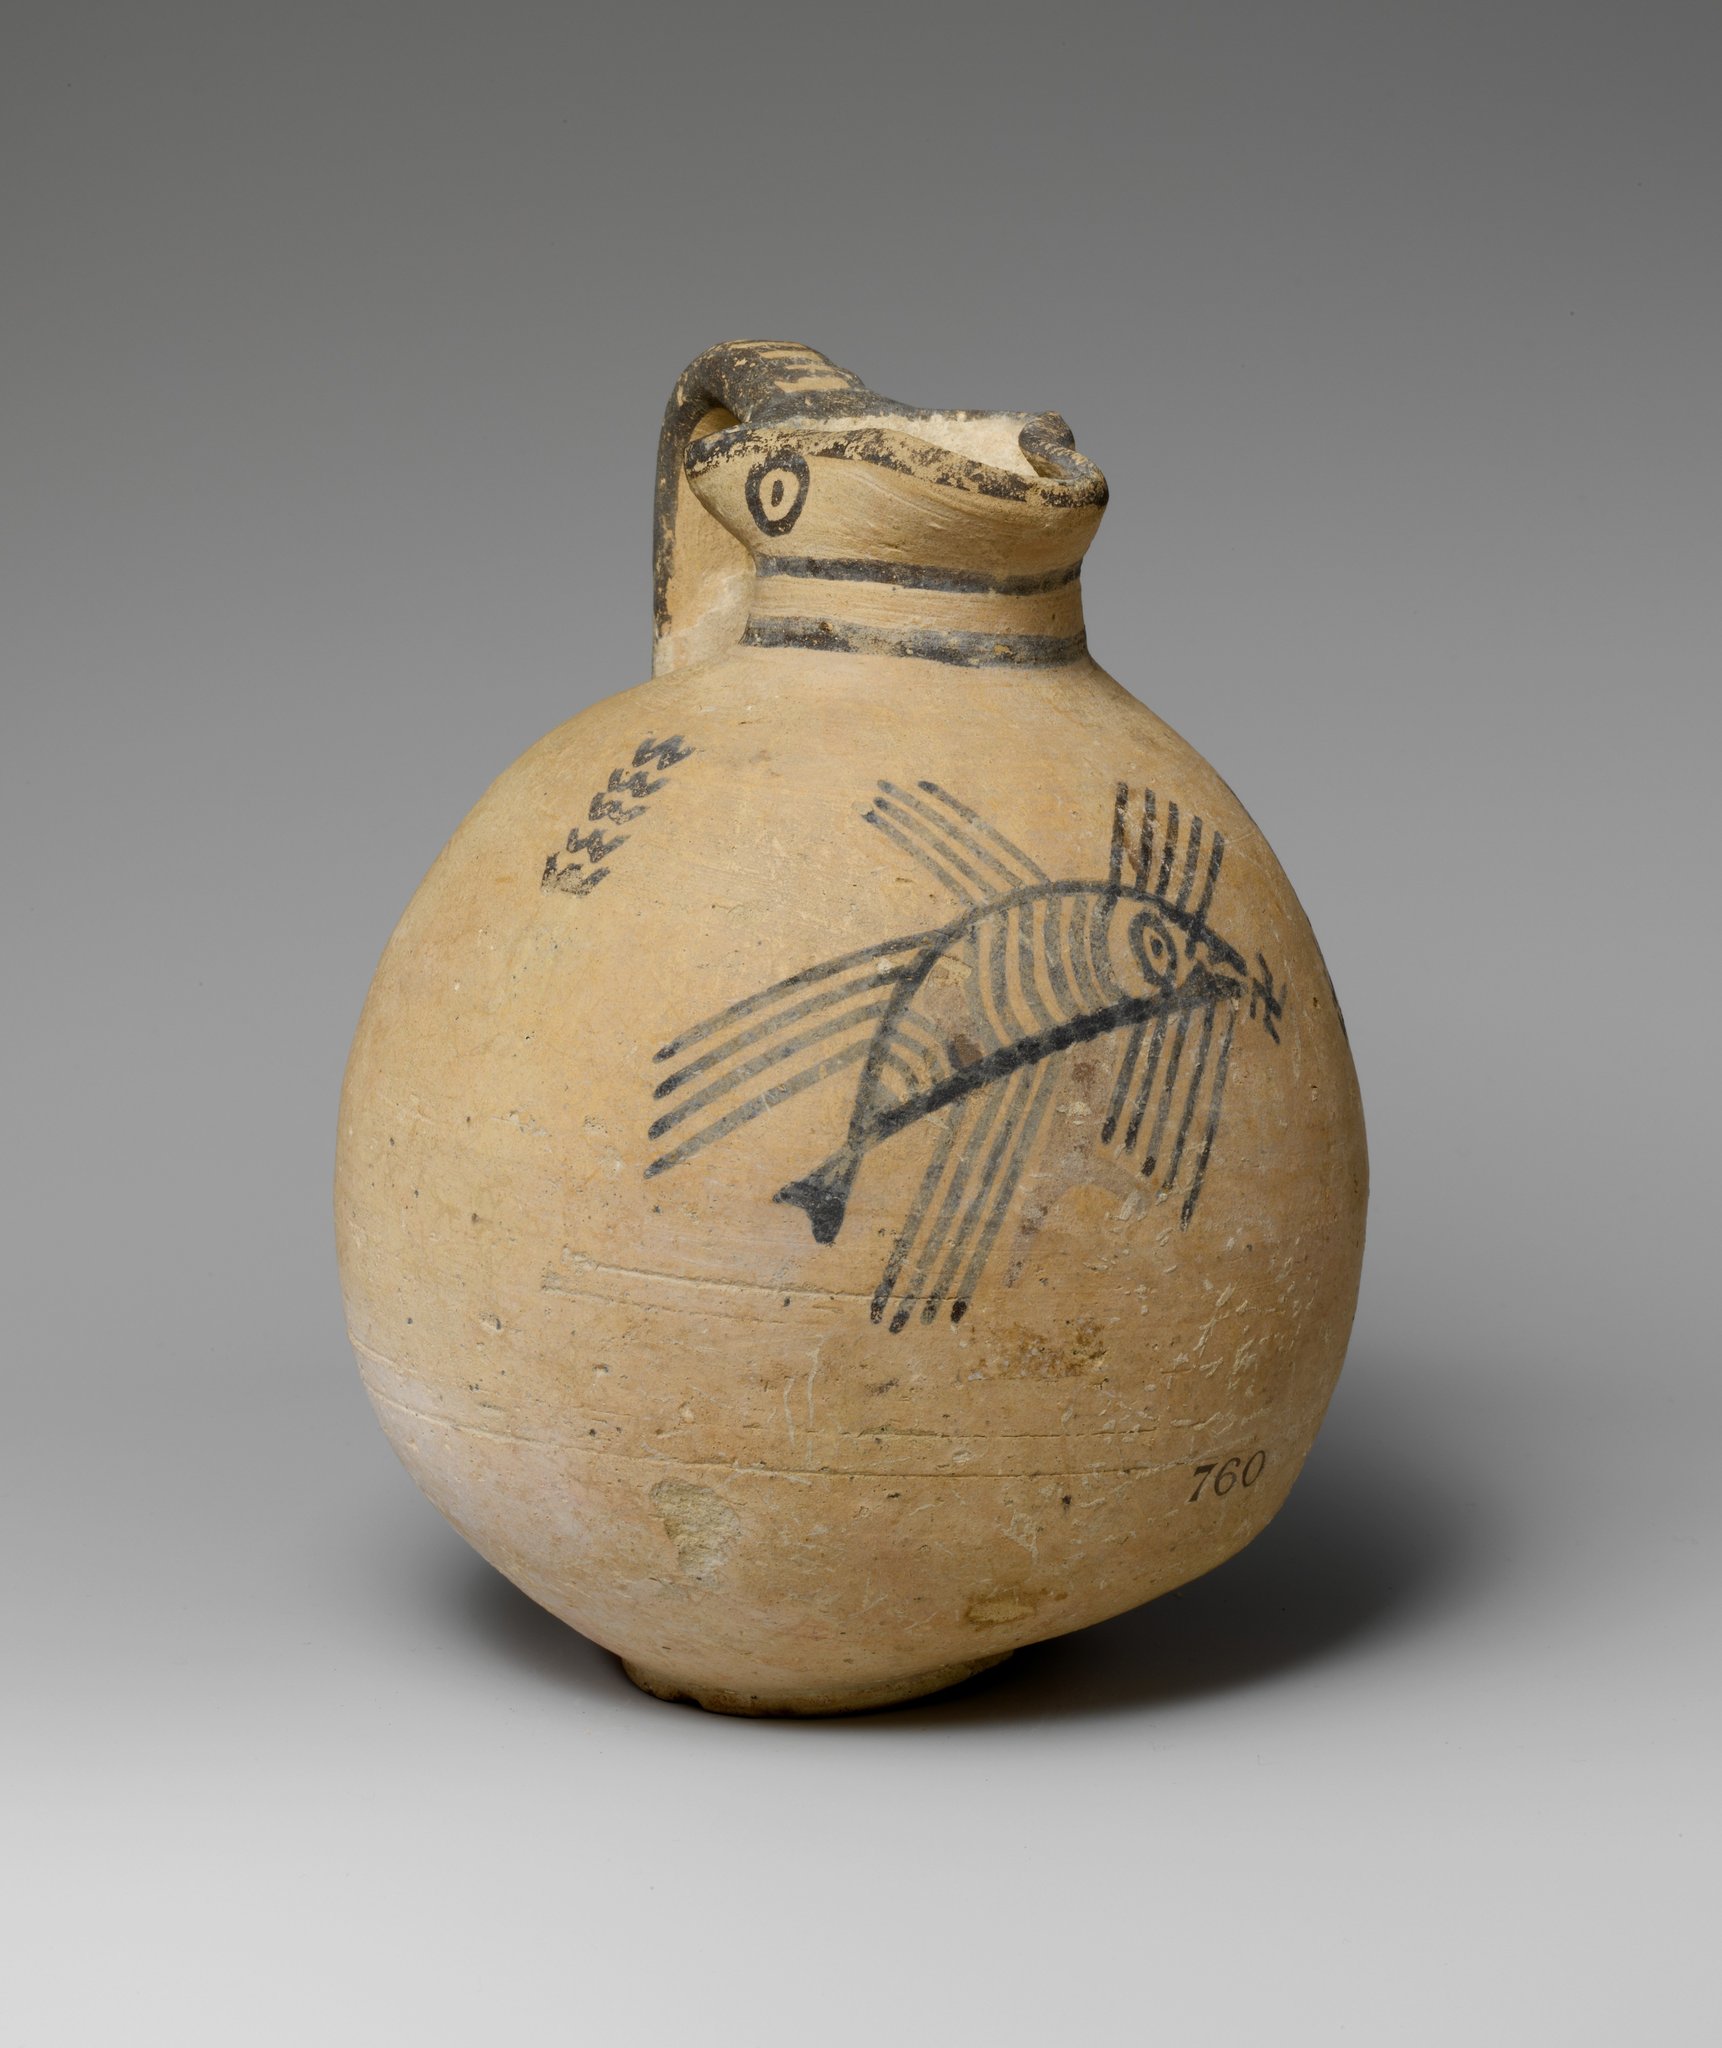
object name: jug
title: Terracotta jug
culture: cypriot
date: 750-600 BCE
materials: terracotta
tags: fish